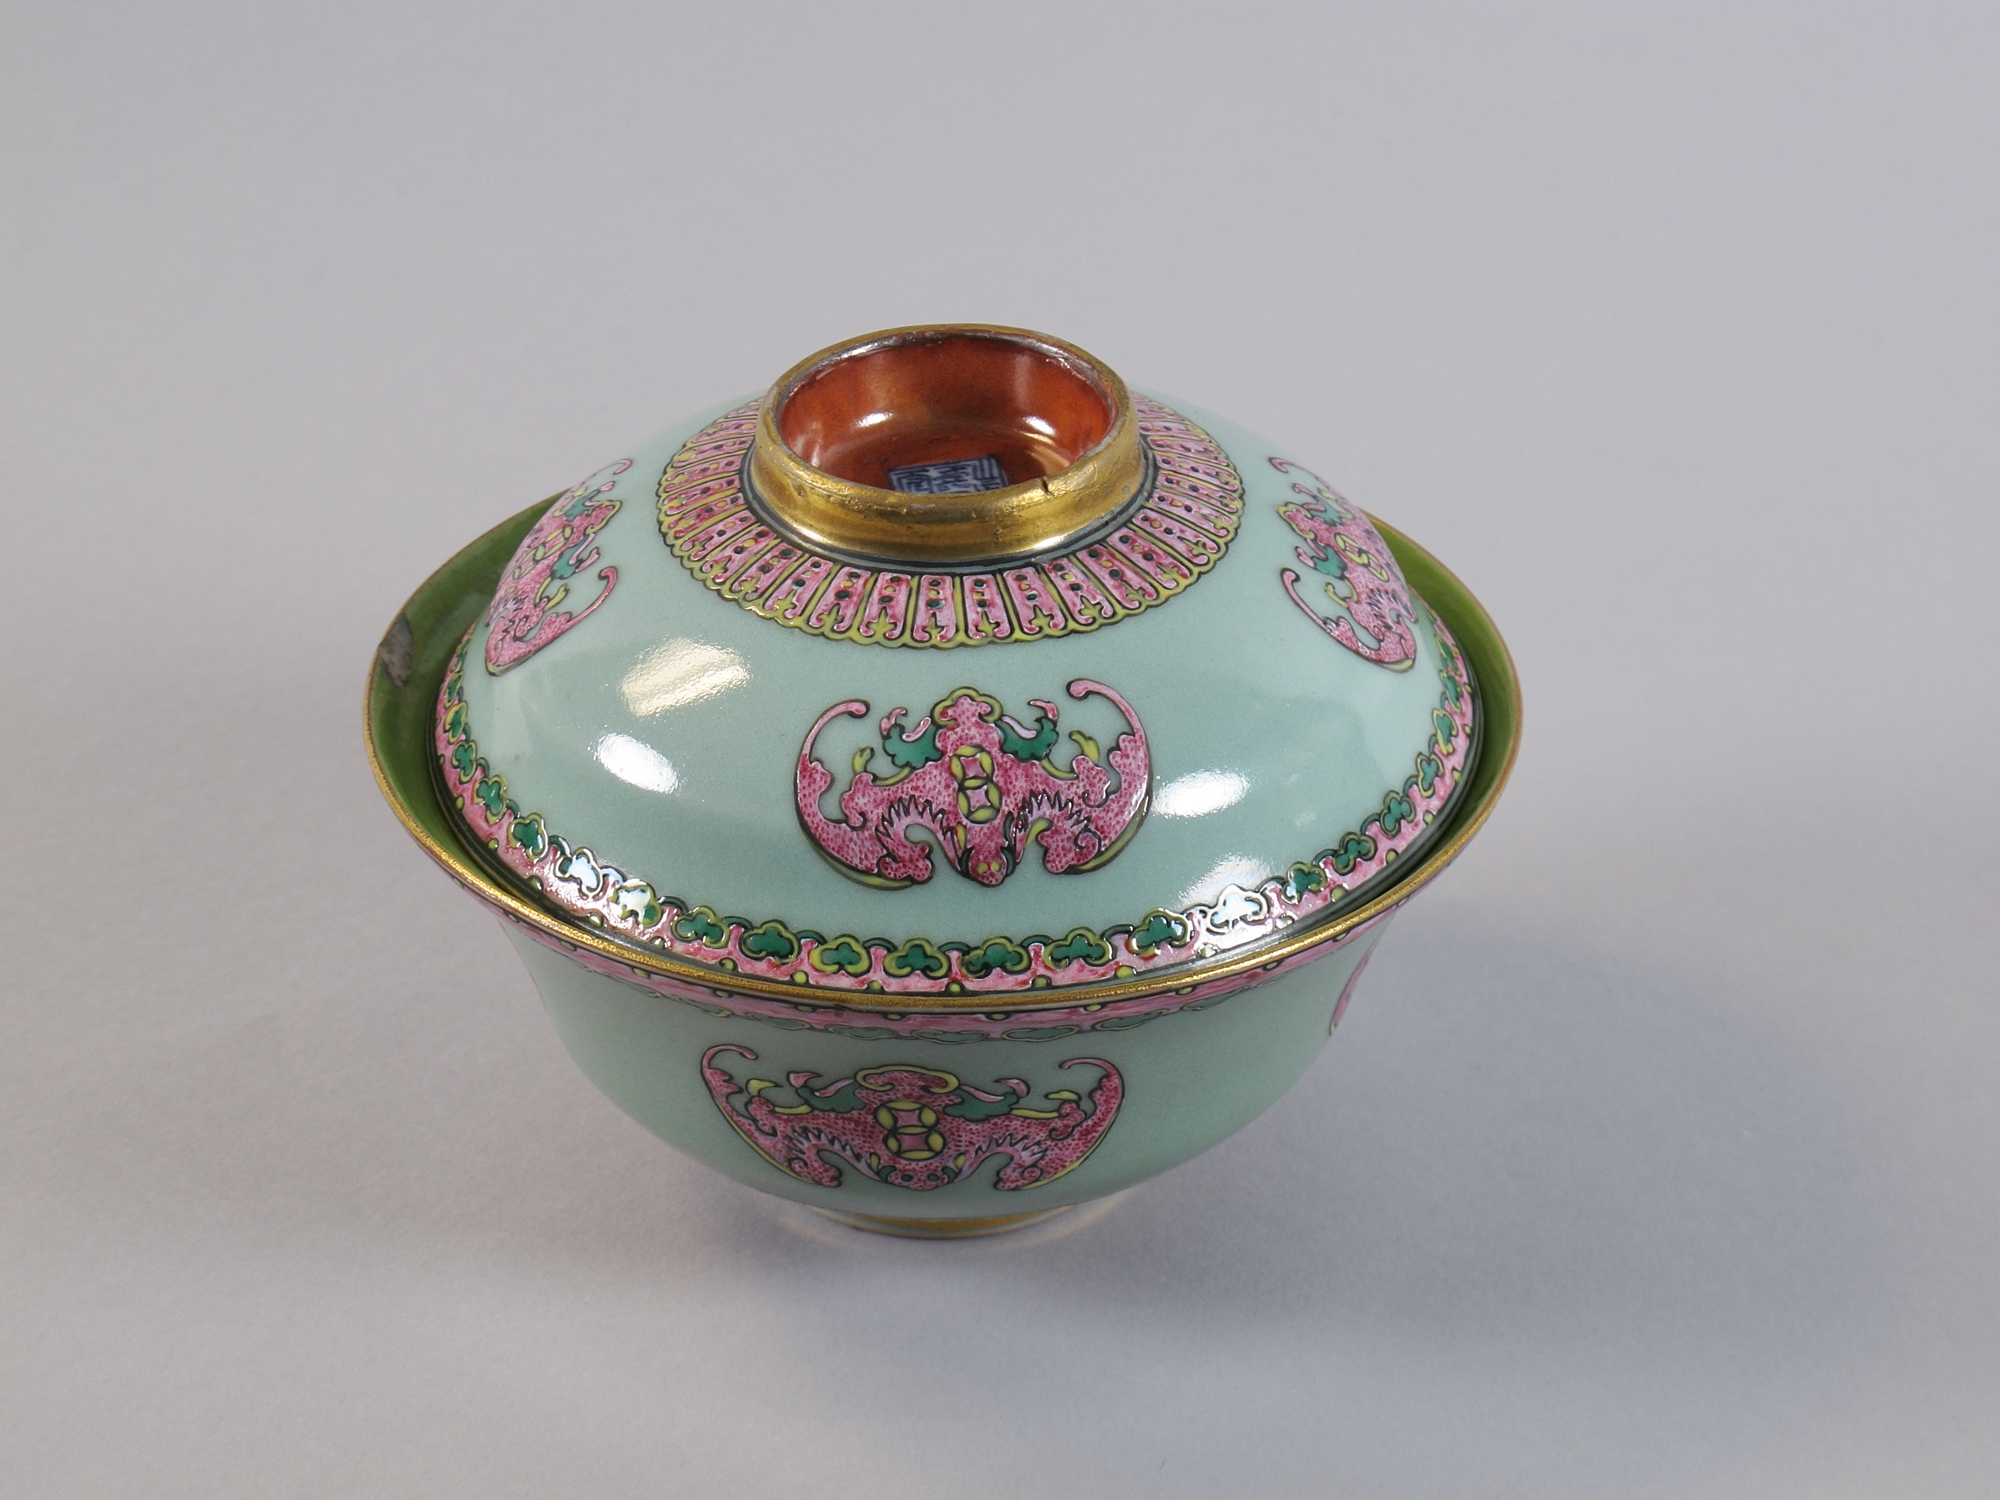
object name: covered bowl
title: Covered bowl with bats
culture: chinese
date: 1767-1833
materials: enamel, glaze, porcelain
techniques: painting, polychrome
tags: bats